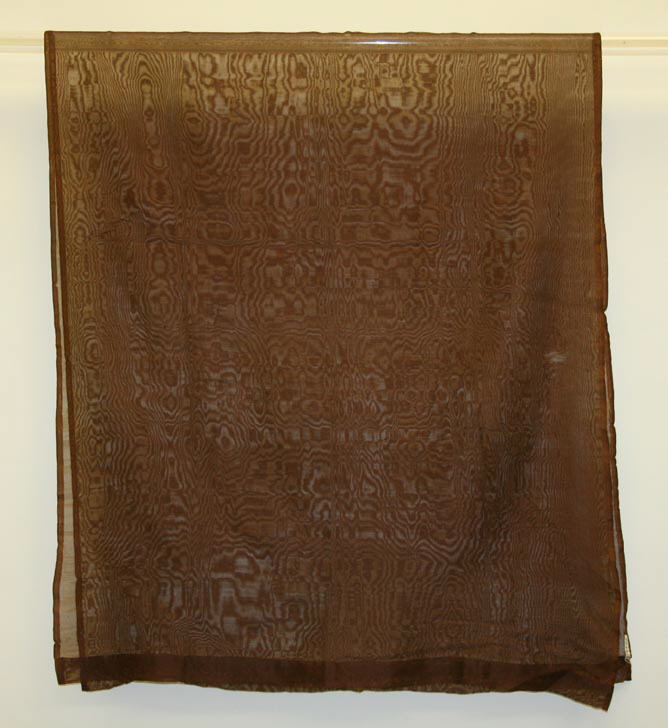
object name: scarf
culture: american or european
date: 1700-1945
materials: silk